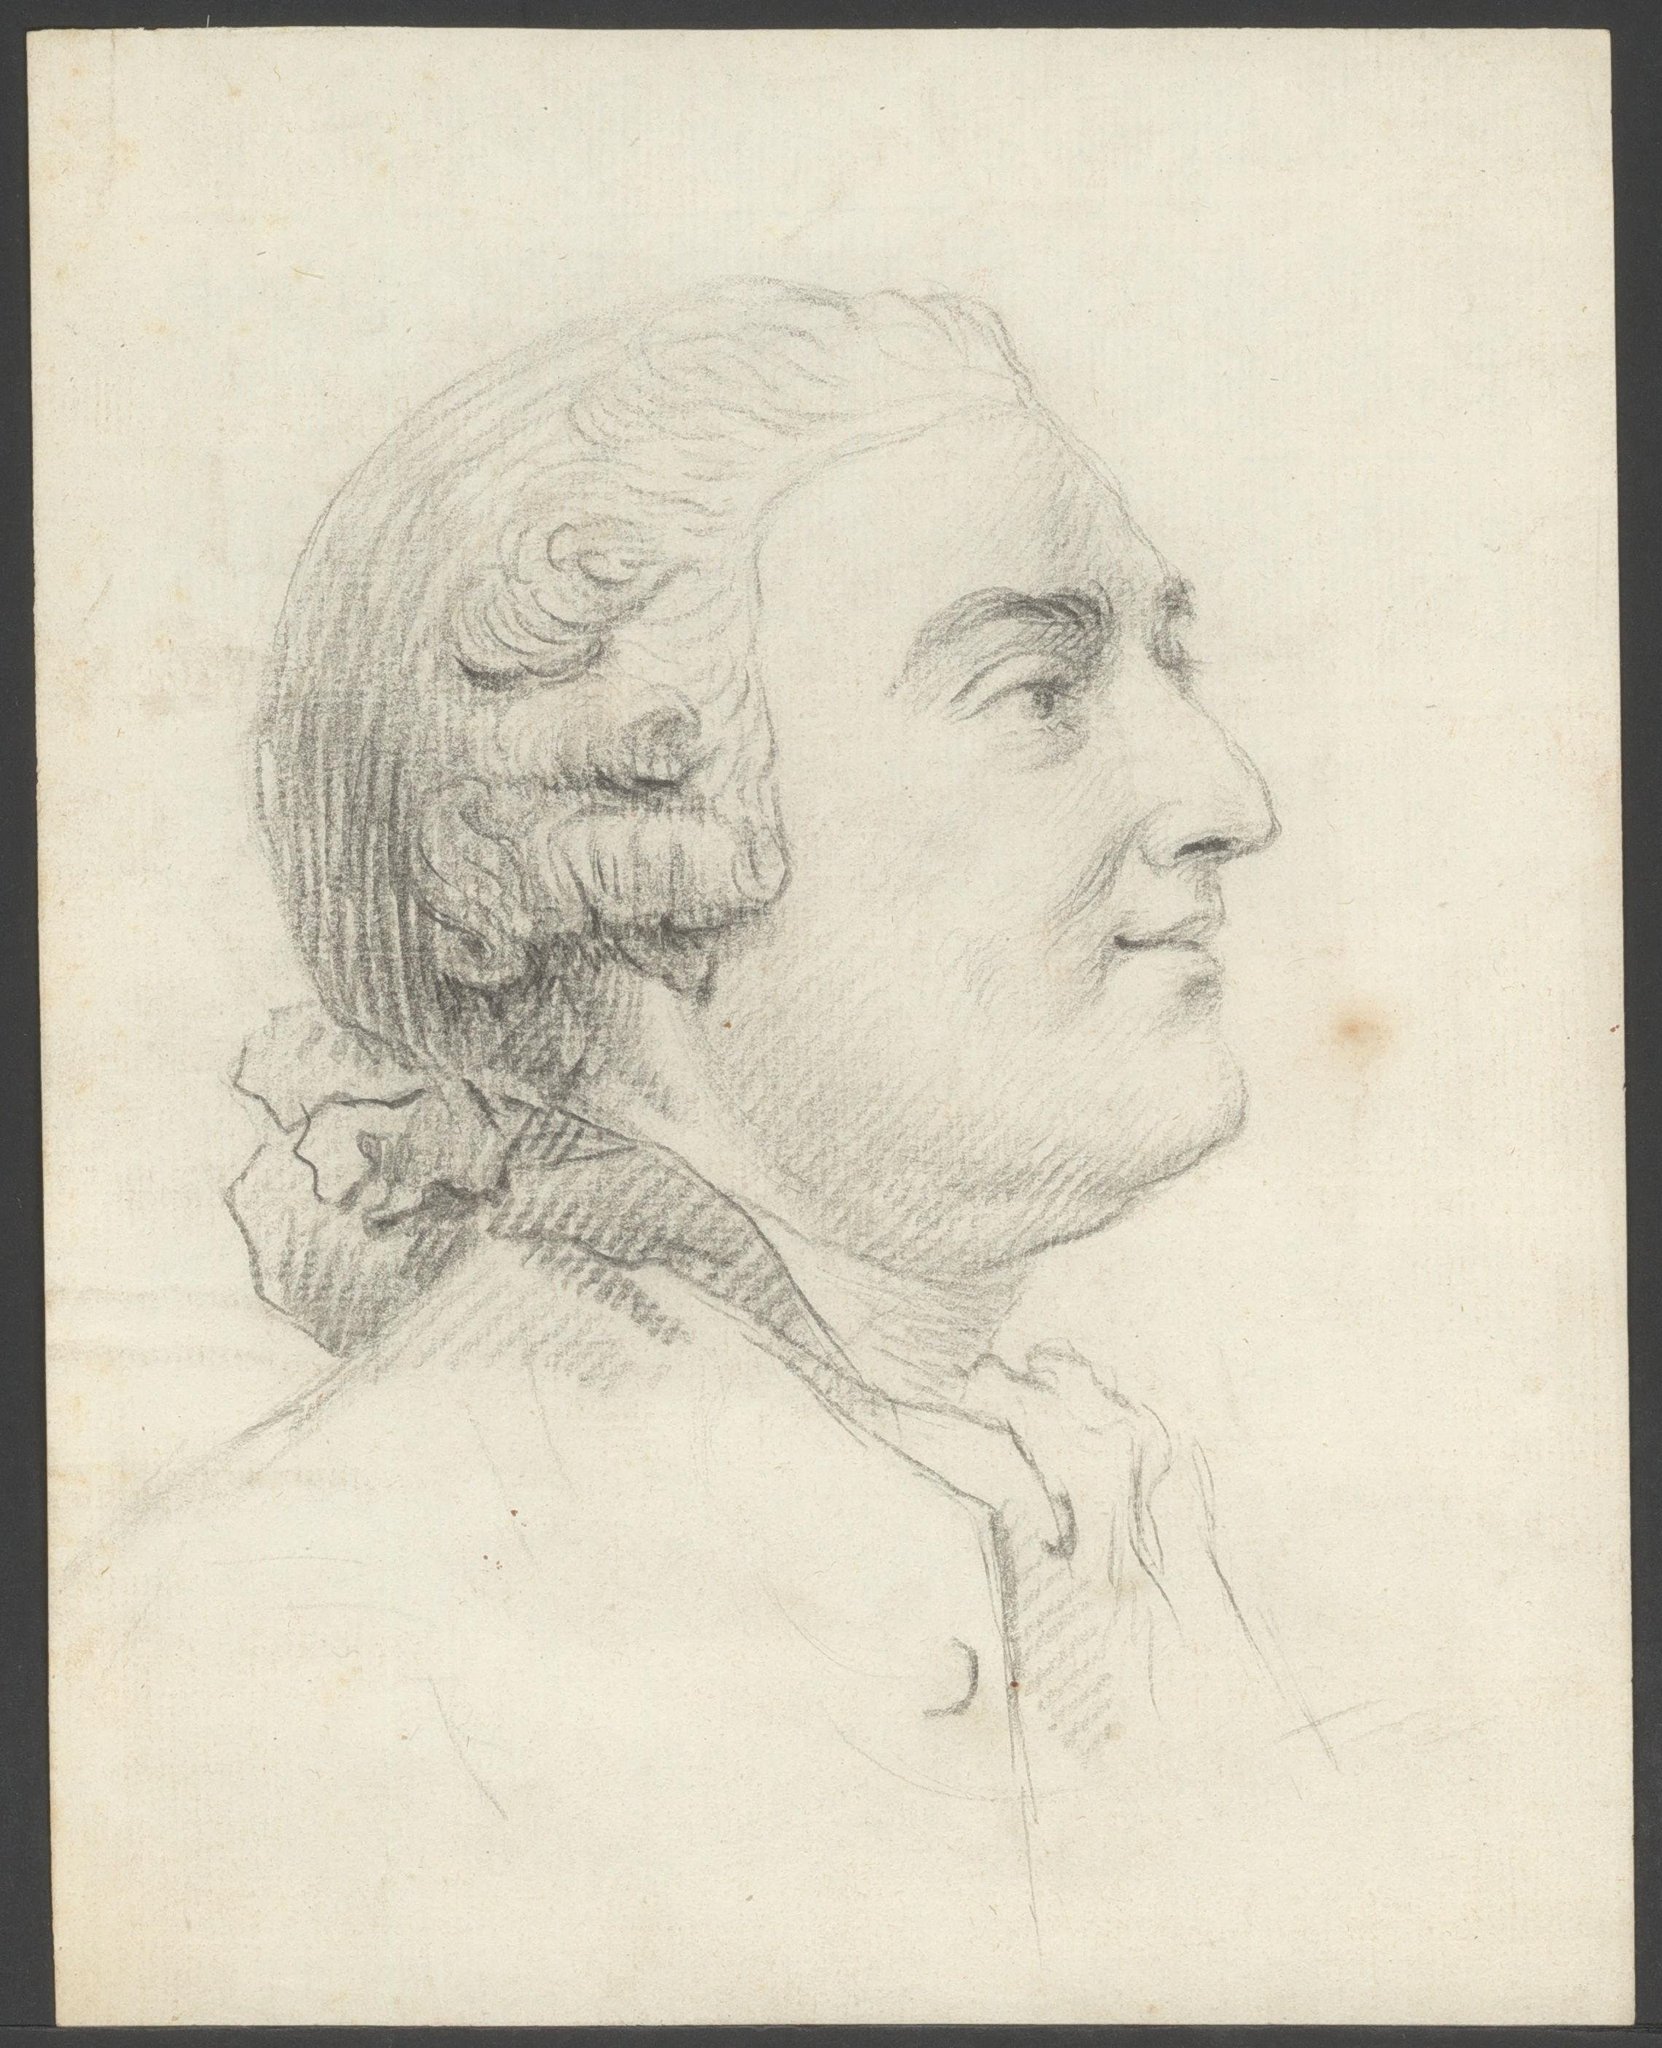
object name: drawing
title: Man met pruik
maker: jean bernard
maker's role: draughtsman, print maker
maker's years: 1765-1833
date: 1775-1833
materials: chalk, paper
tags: face (+ sideview, profile), wig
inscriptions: collector's mark: Lugt 1641, stamp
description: Onderwerpsrubrieken binnen de Atlas Zeden en Gewoonten: Schoone kunsten, Schilderkunst, Tekeningen.